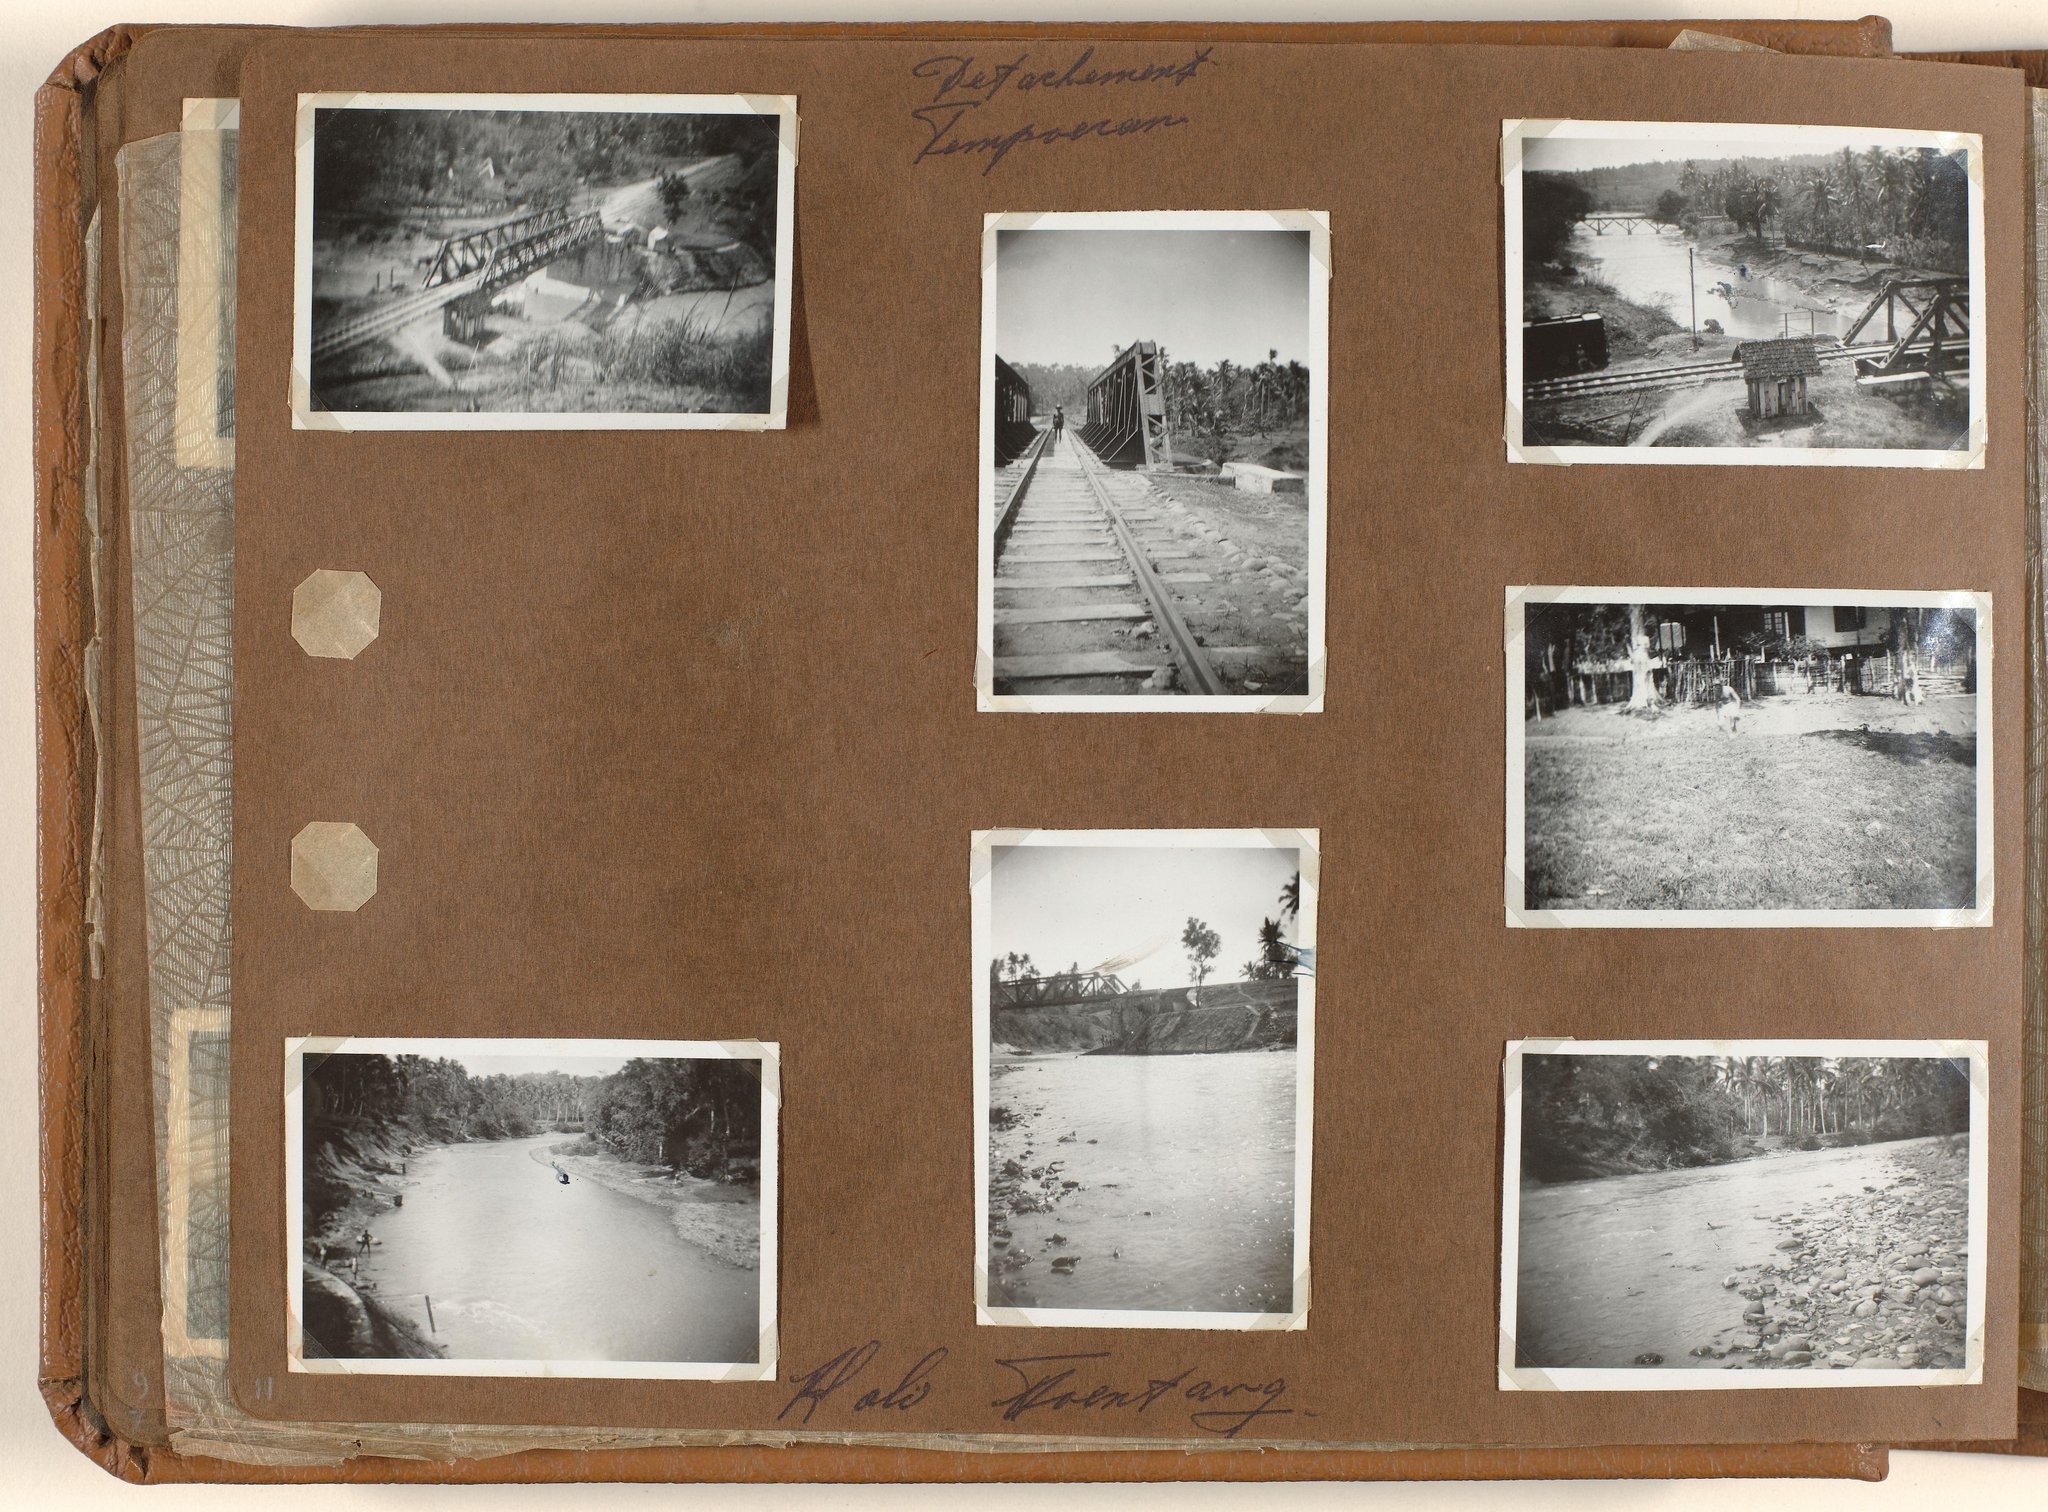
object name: photograph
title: Detachement Tempoeran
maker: Anonymous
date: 1948-1949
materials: paper, photographic support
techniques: photography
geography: central java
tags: troop movements, transportation, landscapes in tropical and sub-tropical regions, dutch east indies, the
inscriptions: annotation: ‘Detachement Tempoeran / Kali Toentang’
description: Het detachement Tempoeran lag ten noordoosten van Salatiga. Kali Toentang is de naam van de rivier die loopt tussen Salatiga en Semarang. Zie ook kaart actiegebied documentatiemap.